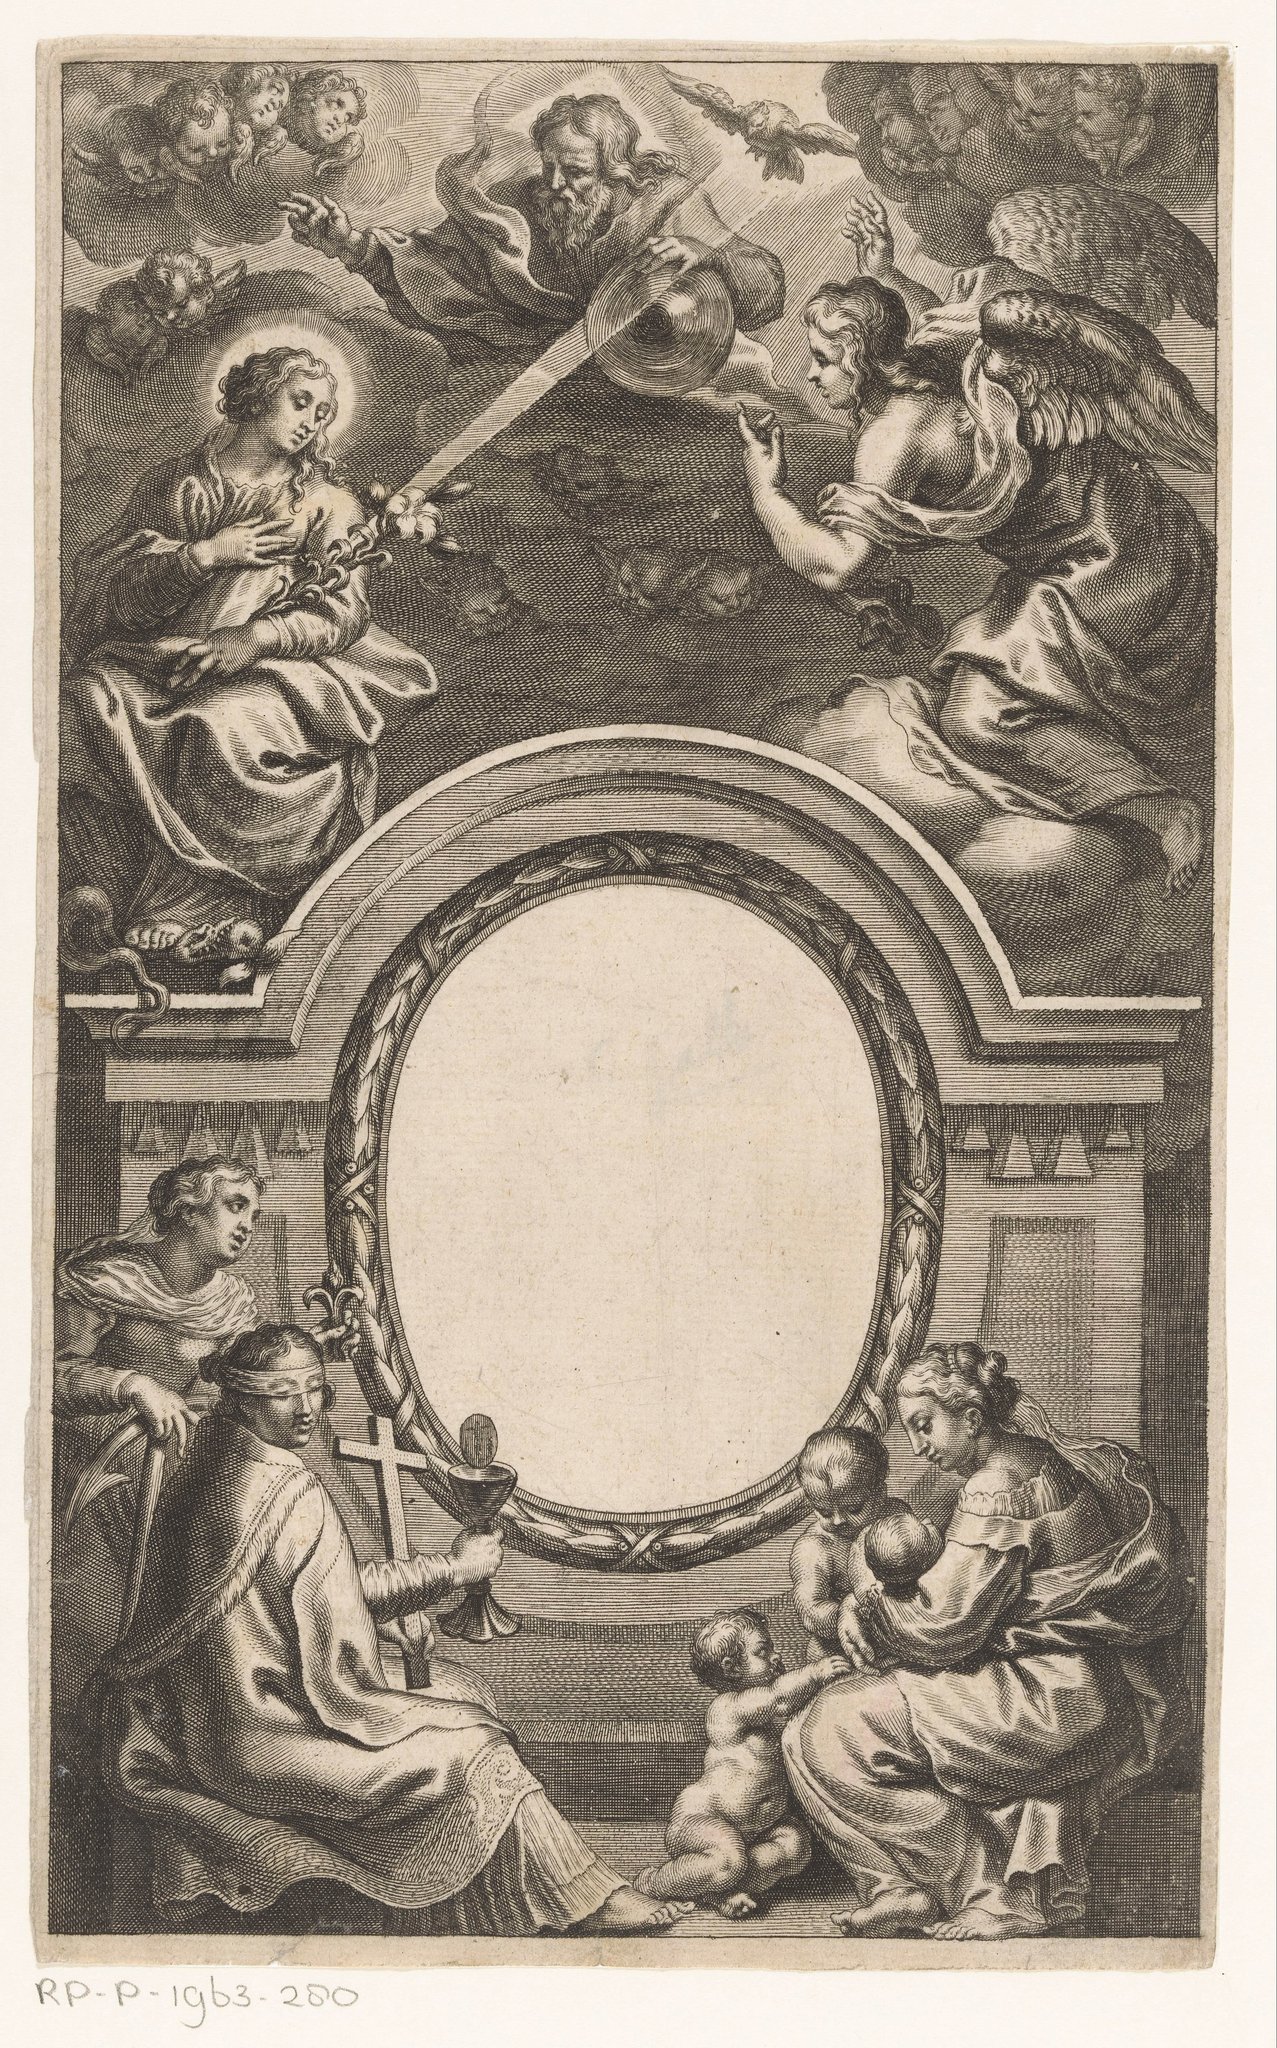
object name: print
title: Allegorische voorstelling met goddelijke deugden en Maria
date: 1600-1700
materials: paper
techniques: engraving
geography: antwerp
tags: mary (without the christ-child), the three theological virtues, god the father, holy ghost represented as a dove (in flames)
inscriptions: collector's mark: Lugt 2760, collector's mark: Lugt 2228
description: Voor een leeg ovaal medaillon zitten de drie goddelijke deugden Geloof (met kruis en kelk), Hoop (met anker) en Liefde (met drie kinderen). Aan de bovenzijde zit links Maria die een slang met appel vertrapt. Rechts zit een engel. In het midden verschijnt God met globe vanachter de wolken. Rechts vliegt een duif als symbool van de heilige geest. Met zijn stralen schijnt hij op de lelie die door Maria vastgehouden wordt.